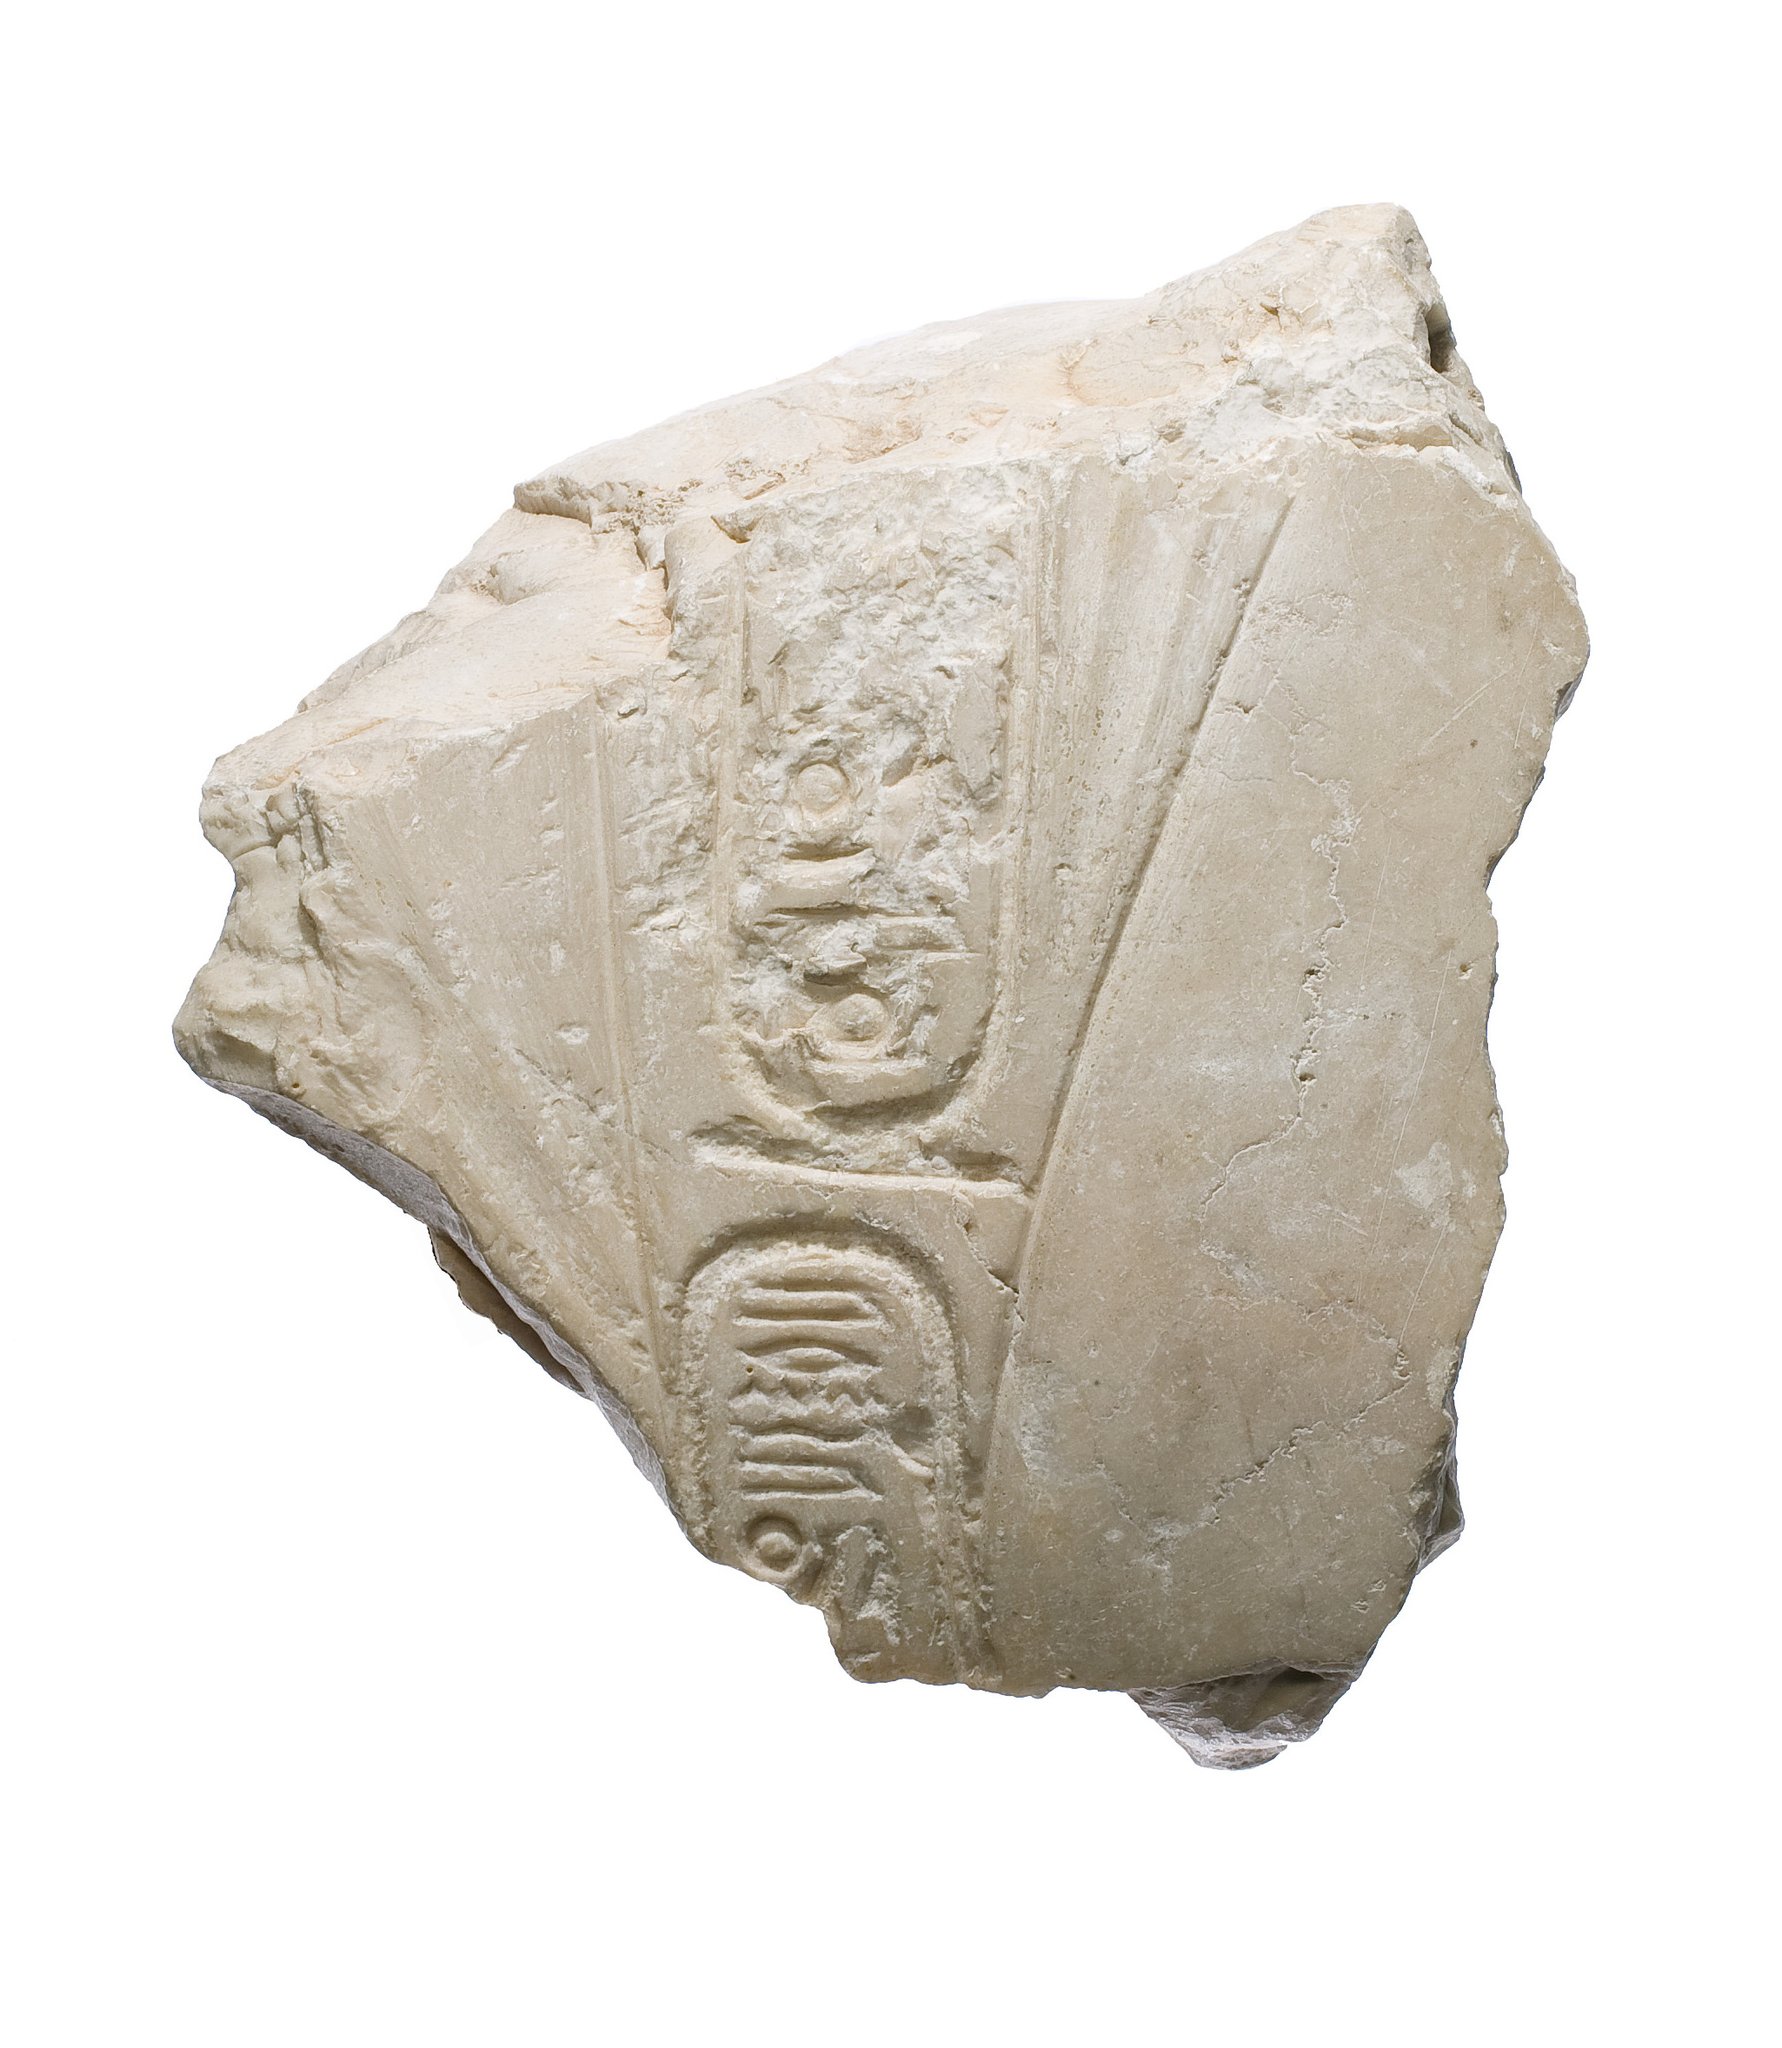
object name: akhenaten prostrate, belt, aten cartouche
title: Belt with Aten cartouche from Akhenaten prostrate (?)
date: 1352-1336 BCE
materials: limestone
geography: egypt